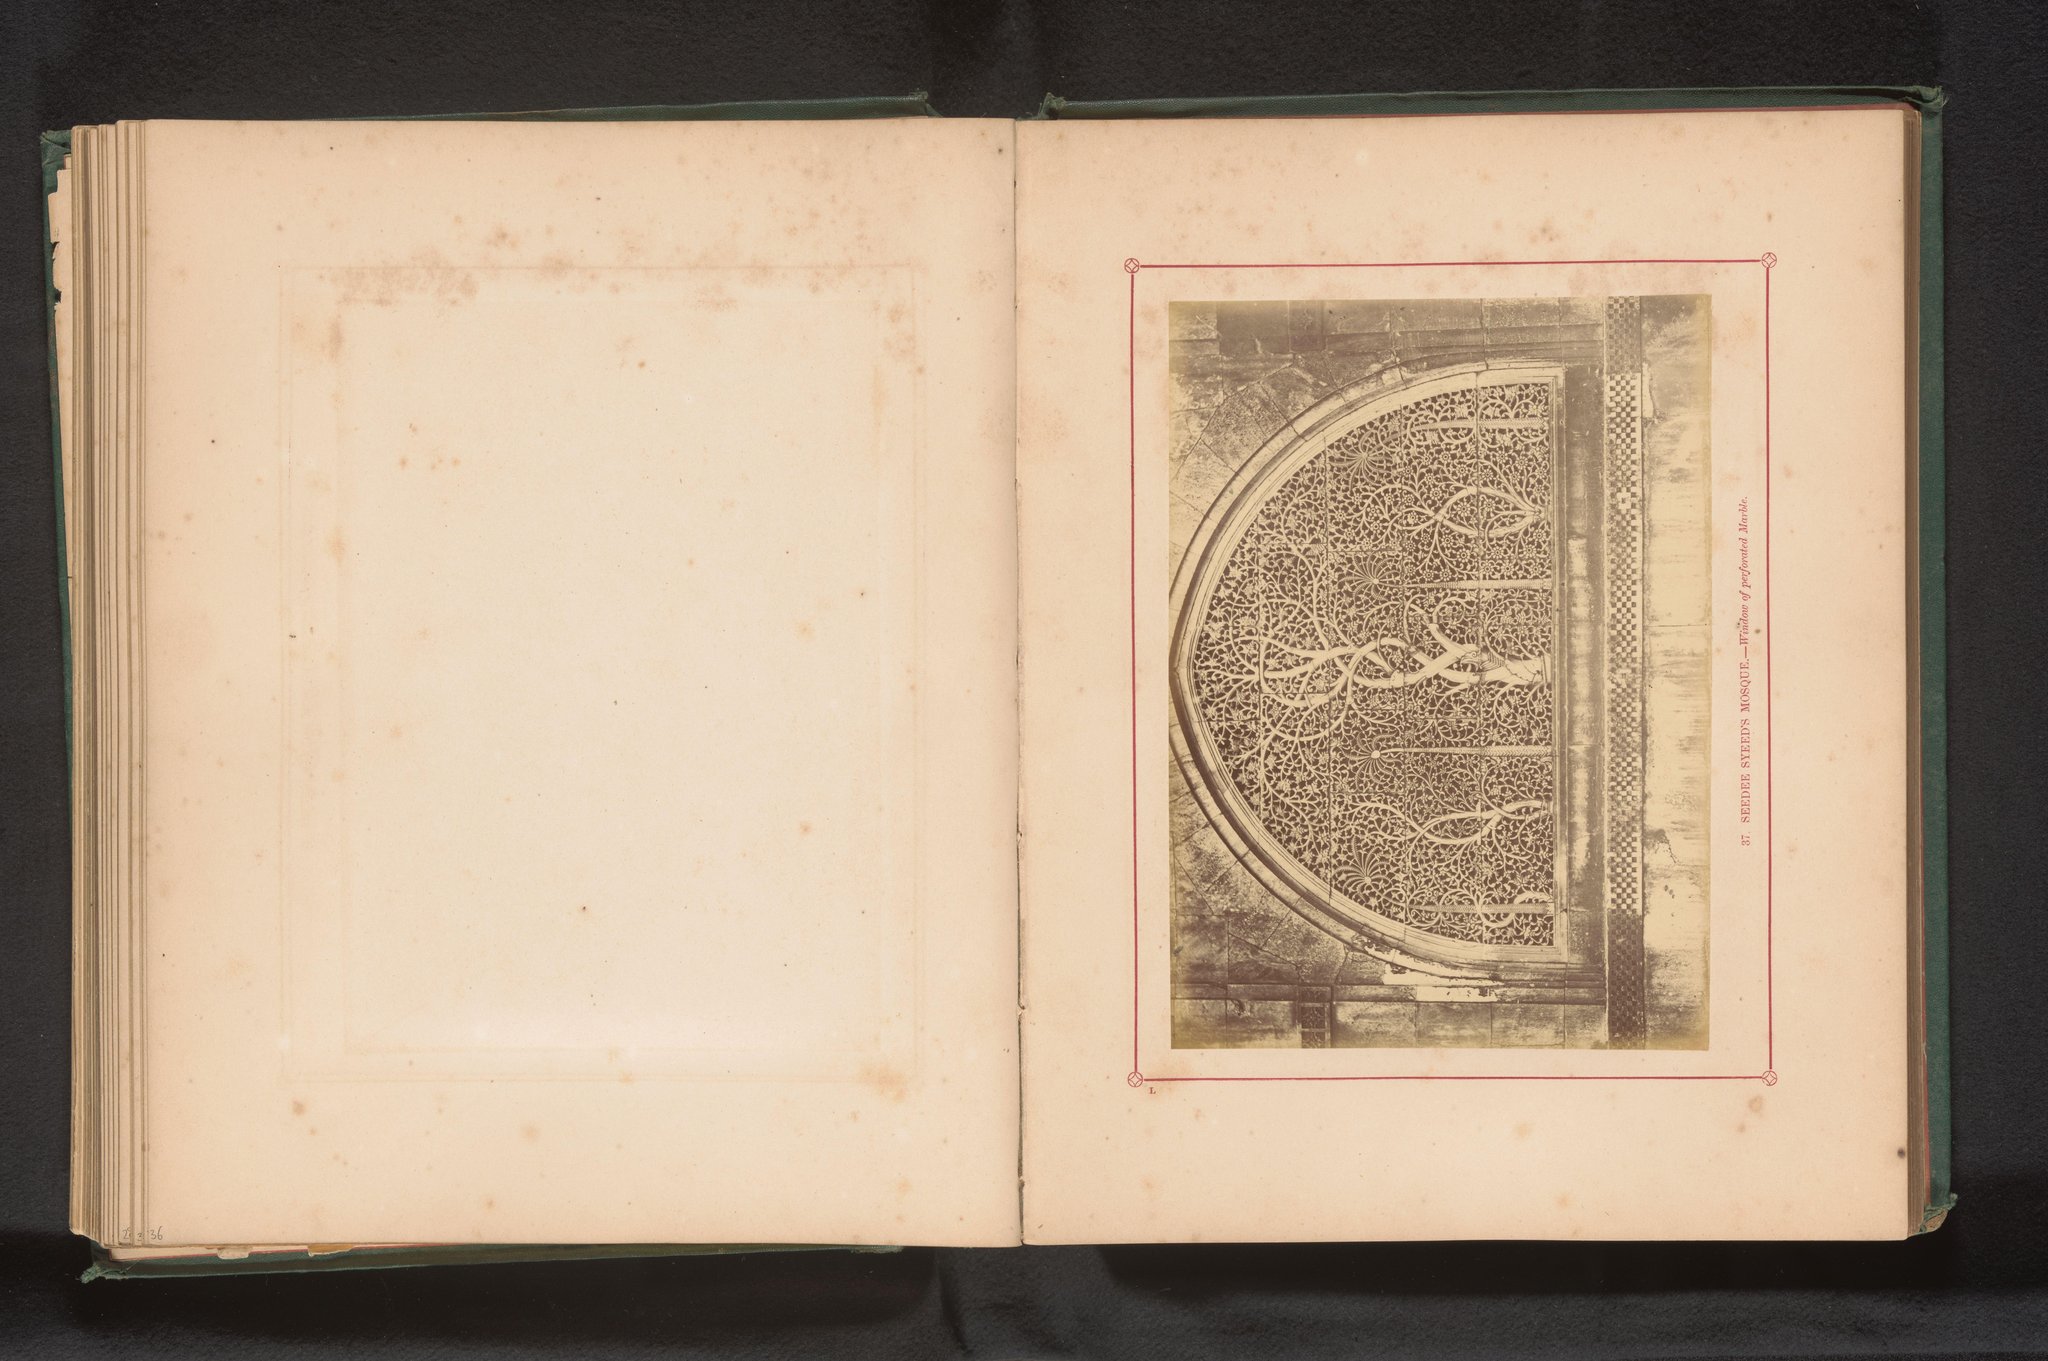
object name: photograph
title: Seedee Syeed's Mosque.- Window of perforated Marble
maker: thomas biggs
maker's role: fotograaf, kapitein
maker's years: 1822-1905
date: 1856-1866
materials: photographic support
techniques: albumen print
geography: ahmedabad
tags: window, temple, shrine ~ islam, mohammedanism, ornament derived from plant forms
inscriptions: number: ‘37.’, inscription: ‘L’